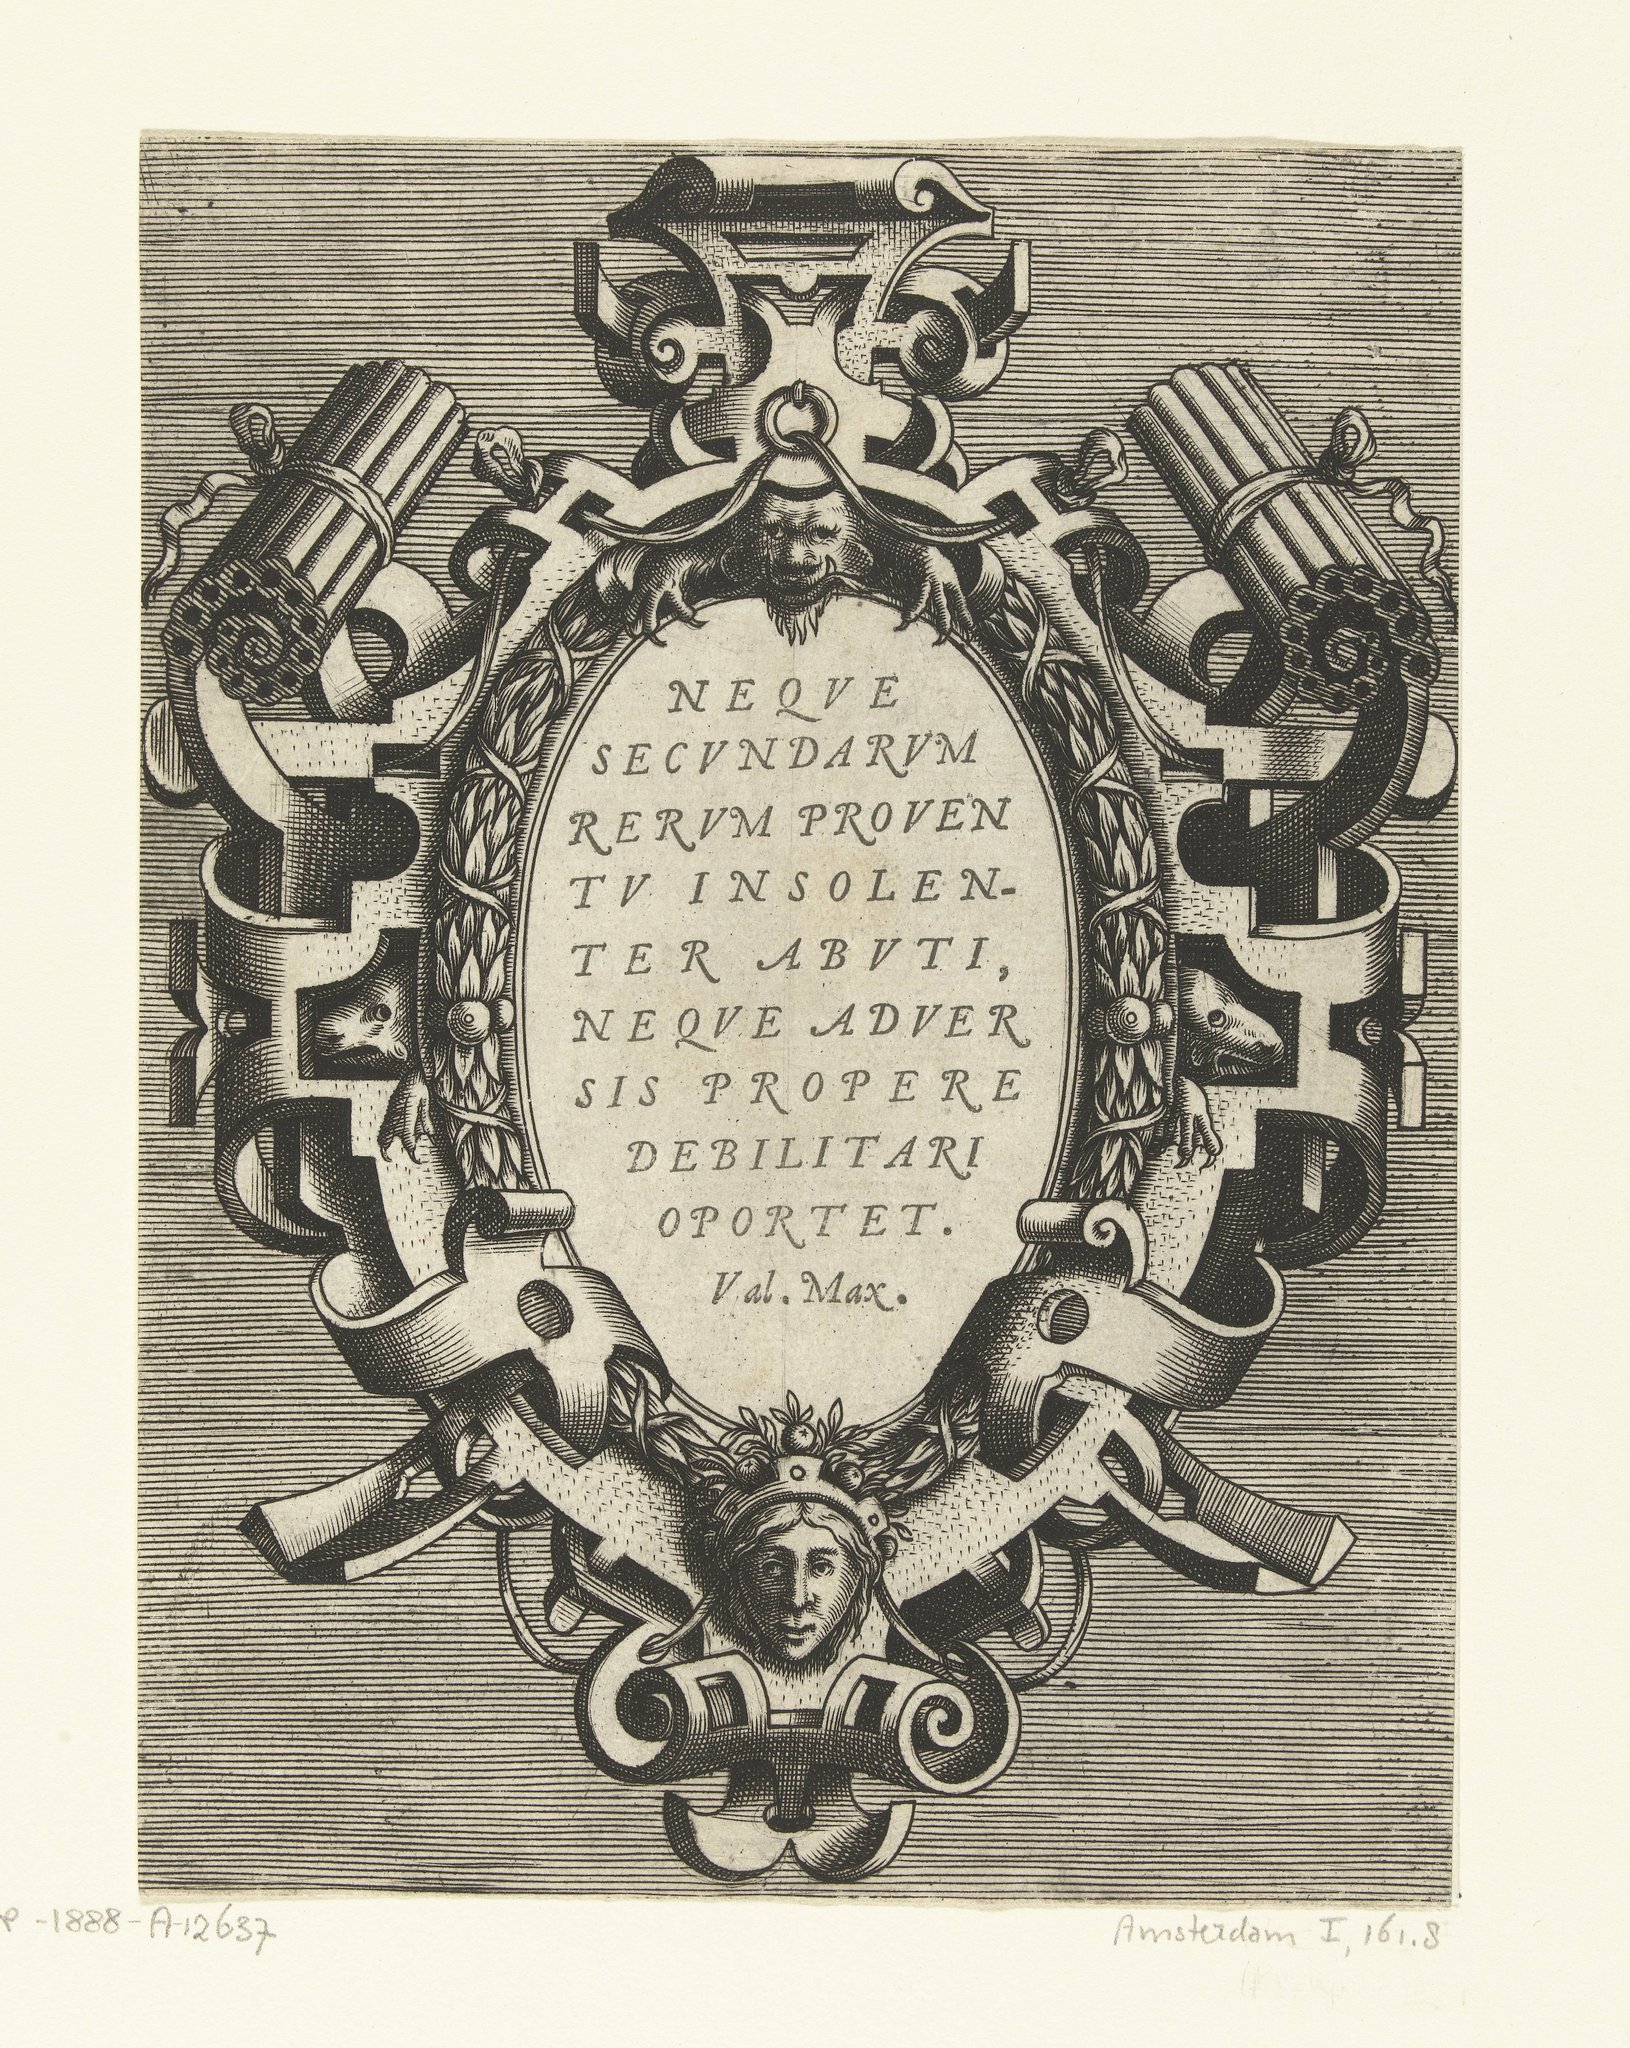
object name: print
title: Ovale cartouche met een citaat van Valerius Maximus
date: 1555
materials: paper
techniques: etching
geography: netherlands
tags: ornament ~ cartouche, mask, mascaron ~ ornament, ornament ~ festoon, garland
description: Citaat: NEQVE SECVNDARVM RERVM PROVENTV IN SOLENTER ABVTI....in cartouche. Om de tekst is een rand van laurierbladeren gebonden. Middenboven hangt een mascaron met klauwen. Gearceerde achtergrond. Uit serie van titelblad en 12 bladen met cartouches met citaten van klassieke schrijvers in een omlijsting van rolwerk met grotesken, mascarons en guirlandes.